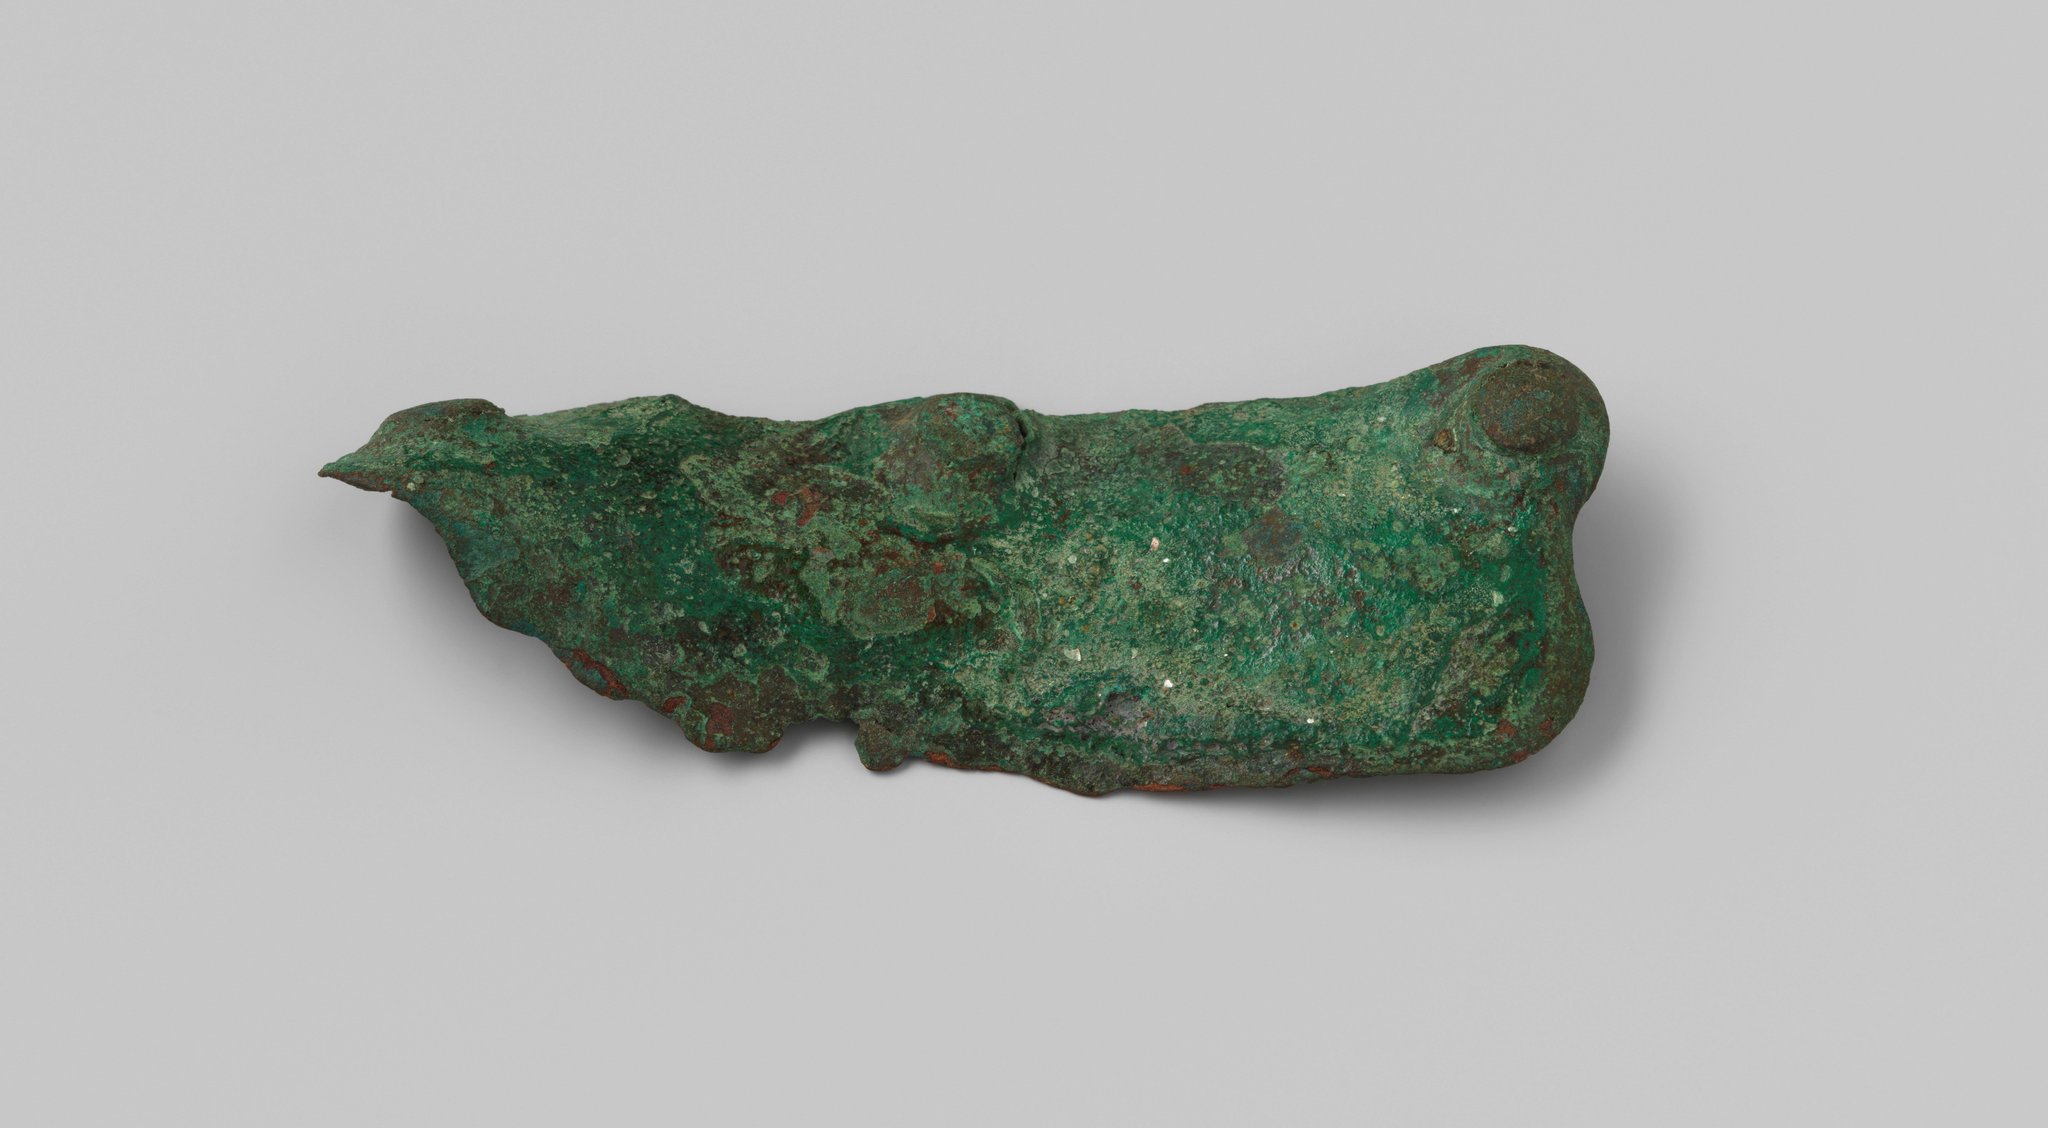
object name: fragment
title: Fragment koperen plaatwerk met klinknagels uit het wrak van de Oost-Indiëvaarder Hollandia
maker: Anonymous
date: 1700-1743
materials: copper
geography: netherlands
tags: verenigde oostindische compagnie, hollandia (schip), annet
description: Varied parts or fragments, sheet metal fragments: worked, with rivets; fragm, eroded, 3 rivets.